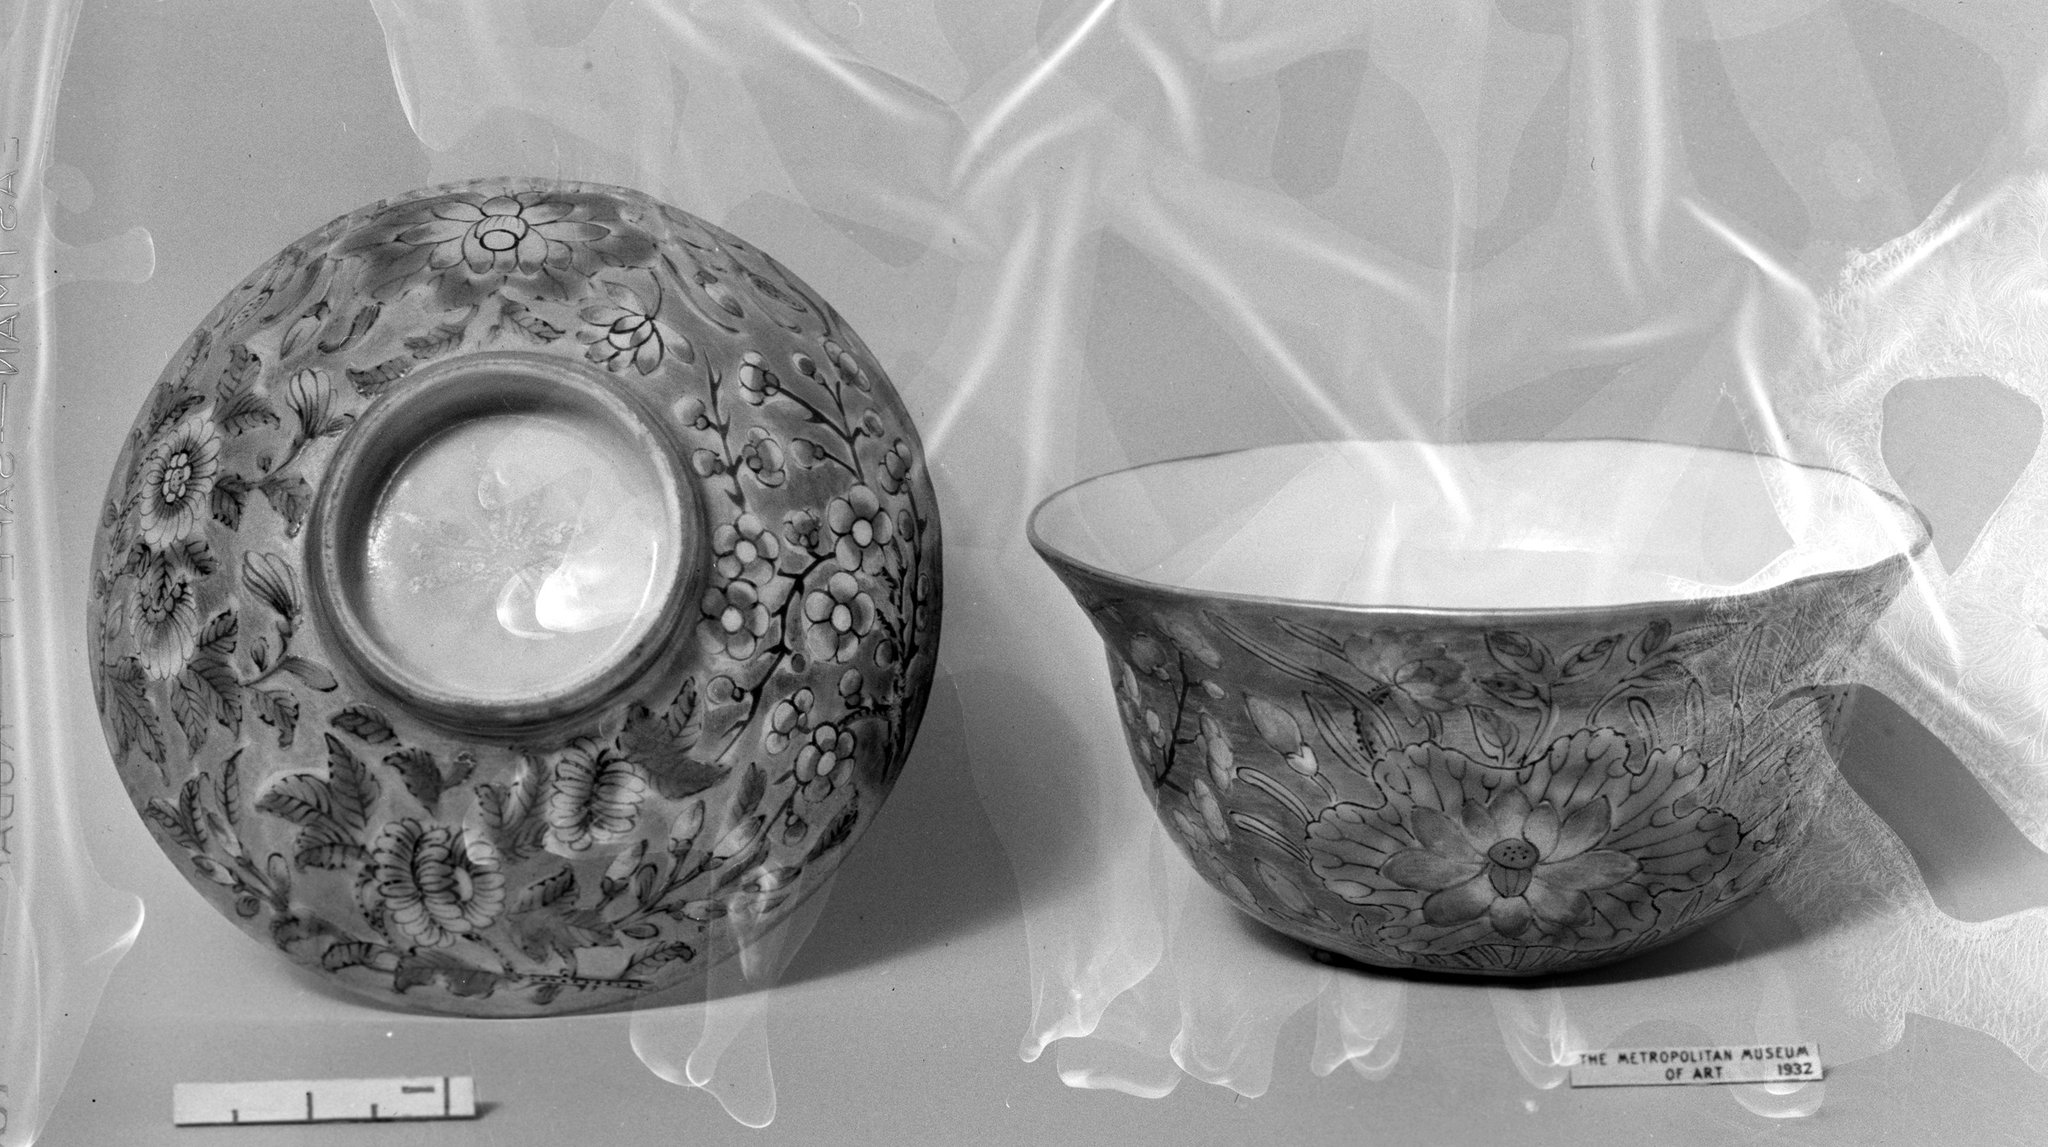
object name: covered bowl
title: Covered bowl with chrysanthemums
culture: chinese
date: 1801-1900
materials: enamel, porcelain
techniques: overglaze, painting, polychrome